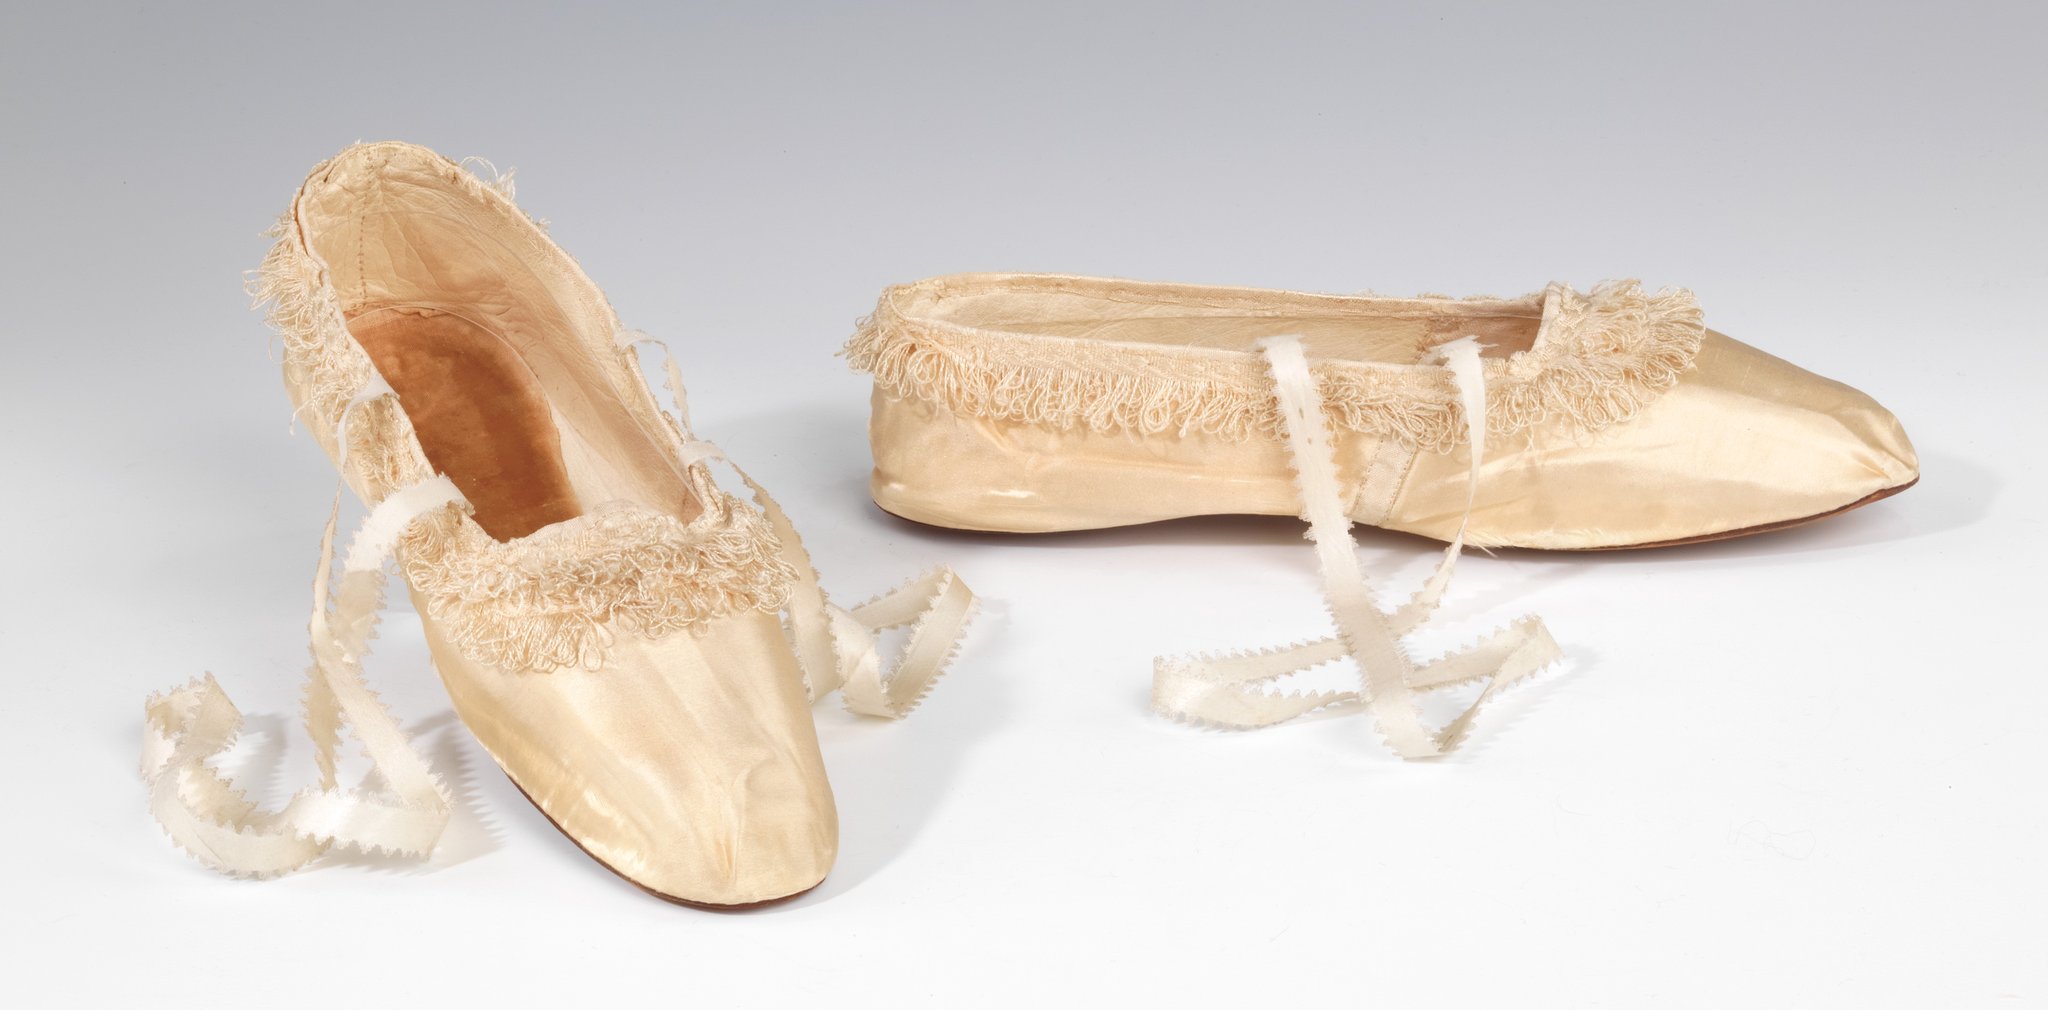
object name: evening slipper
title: Evening slippers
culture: british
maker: hobbs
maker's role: designer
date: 1845-1865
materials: silk